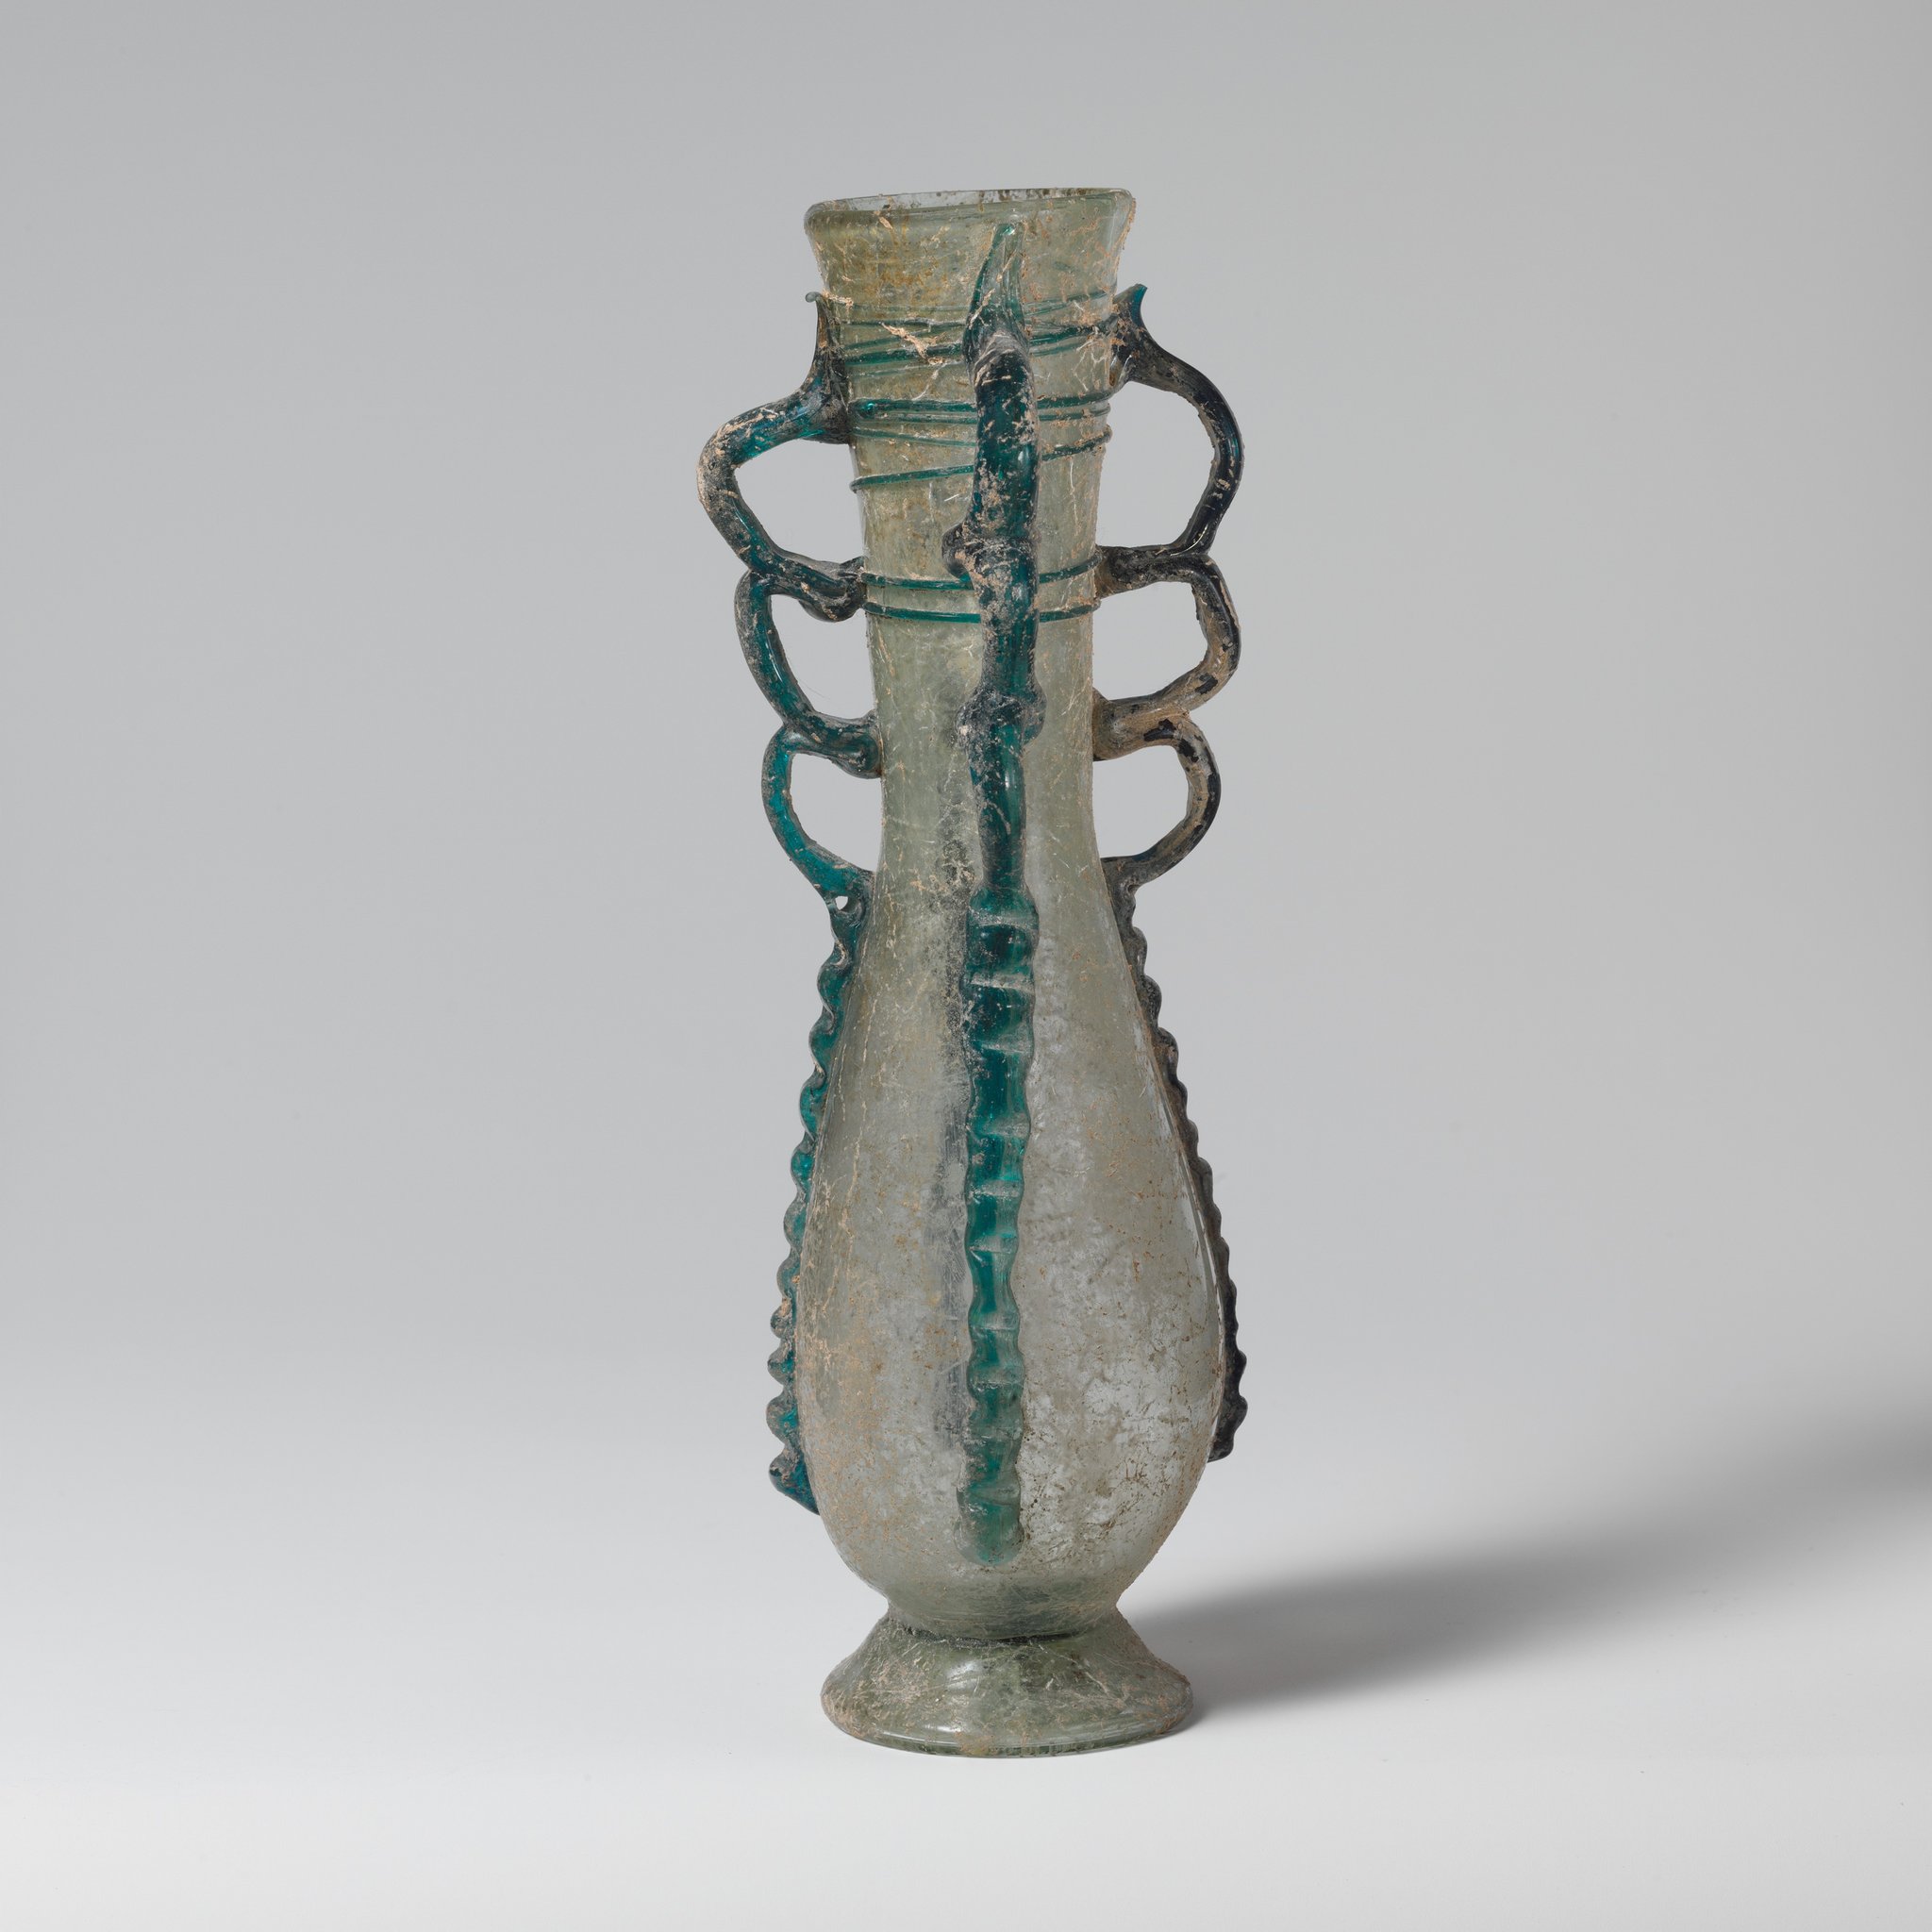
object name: flask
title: Glass flask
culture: roman, syrian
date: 301-600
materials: glass